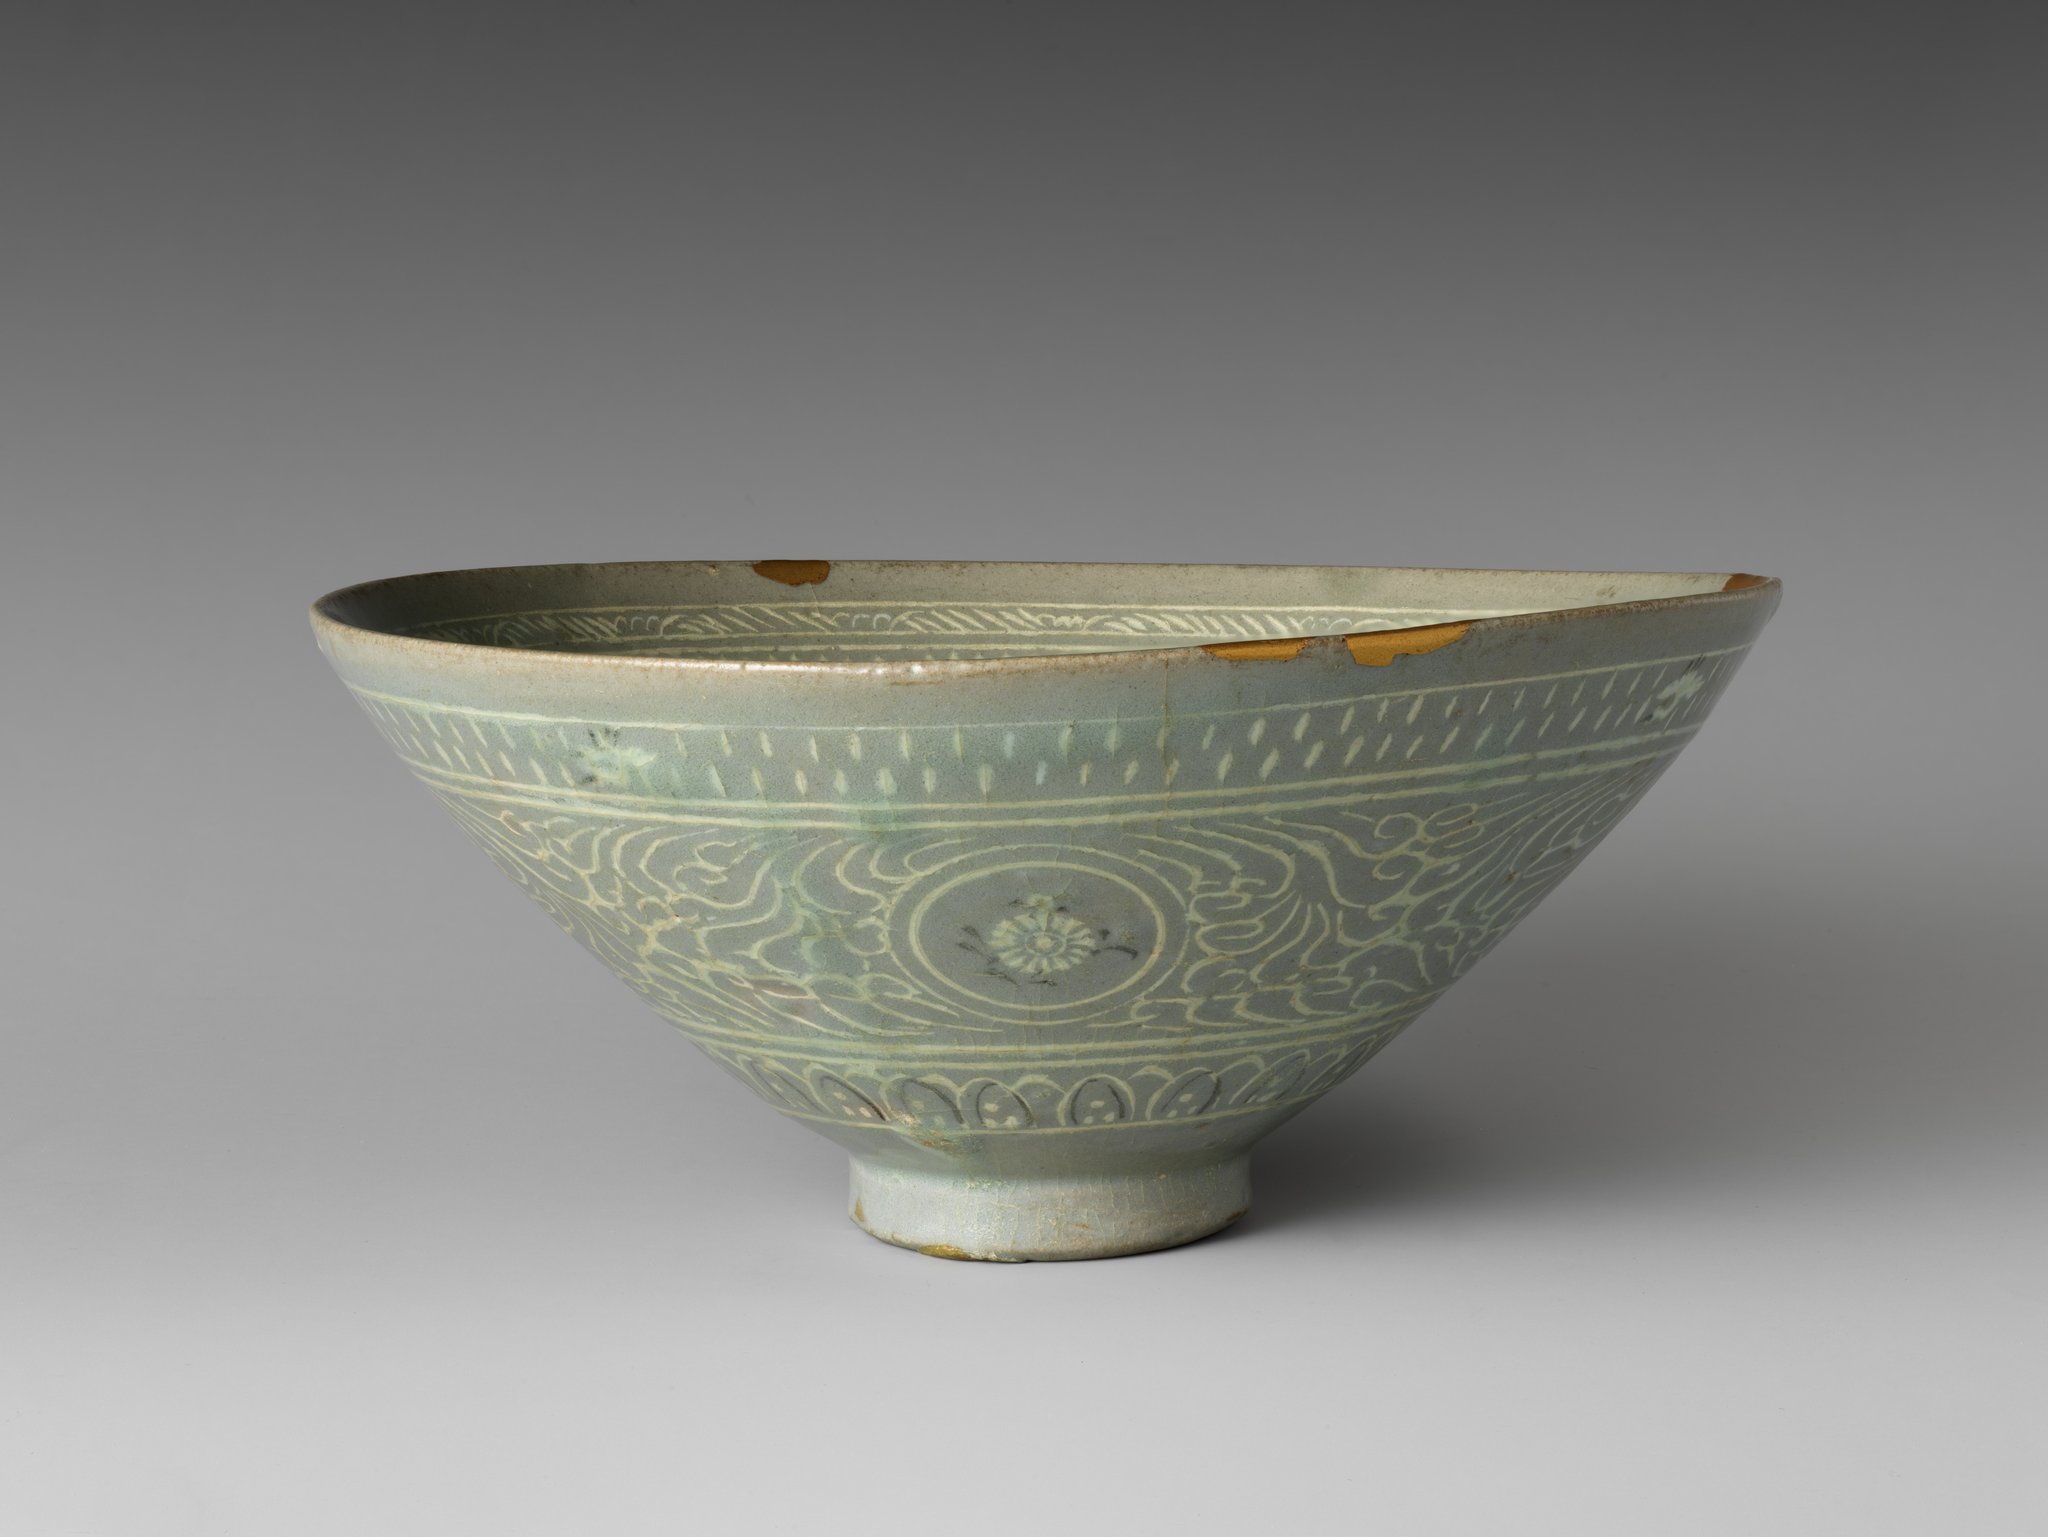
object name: bowl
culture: korean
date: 1201-1300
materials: ceramic glaze, glaze, stoneware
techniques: inlay